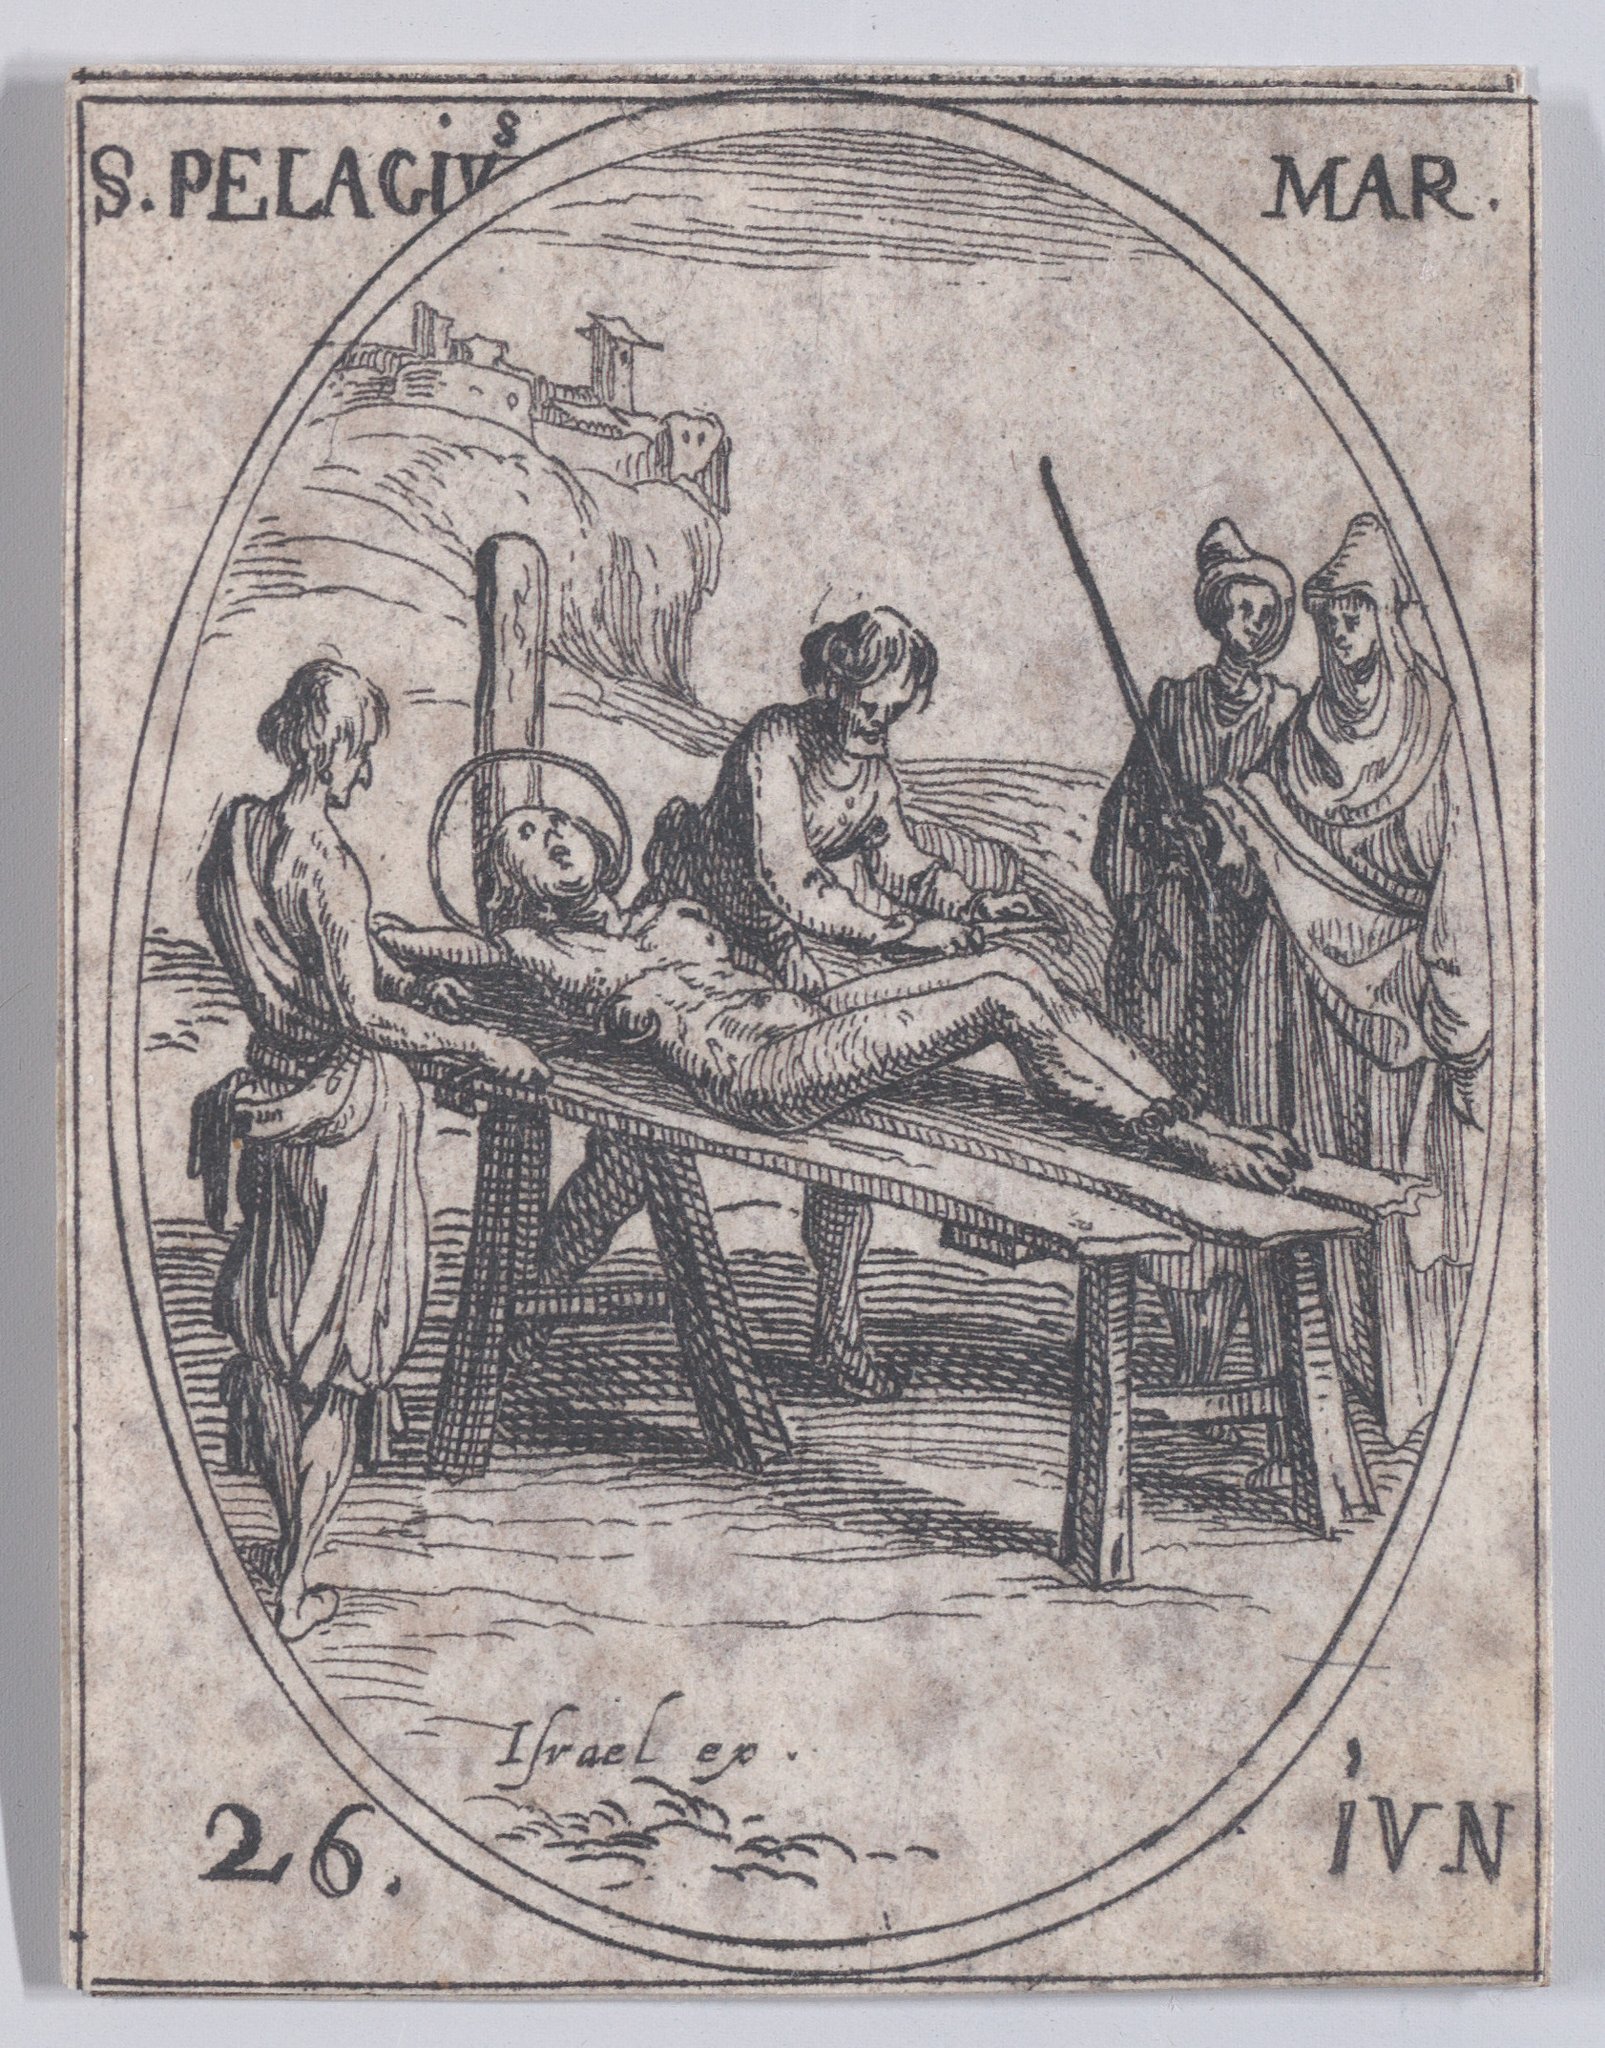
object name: print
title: S. Pelage, martyr (St. Pelagius, Martyr), June 26th, from "Les Images De Tous Les Saincts et Saintes de L'Année" (Images of All of the Saints and Religious Events of the Year)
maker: jacques callot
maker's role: artist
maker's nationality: french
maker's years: 1592-1635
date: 1636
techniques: etching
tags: men,saints